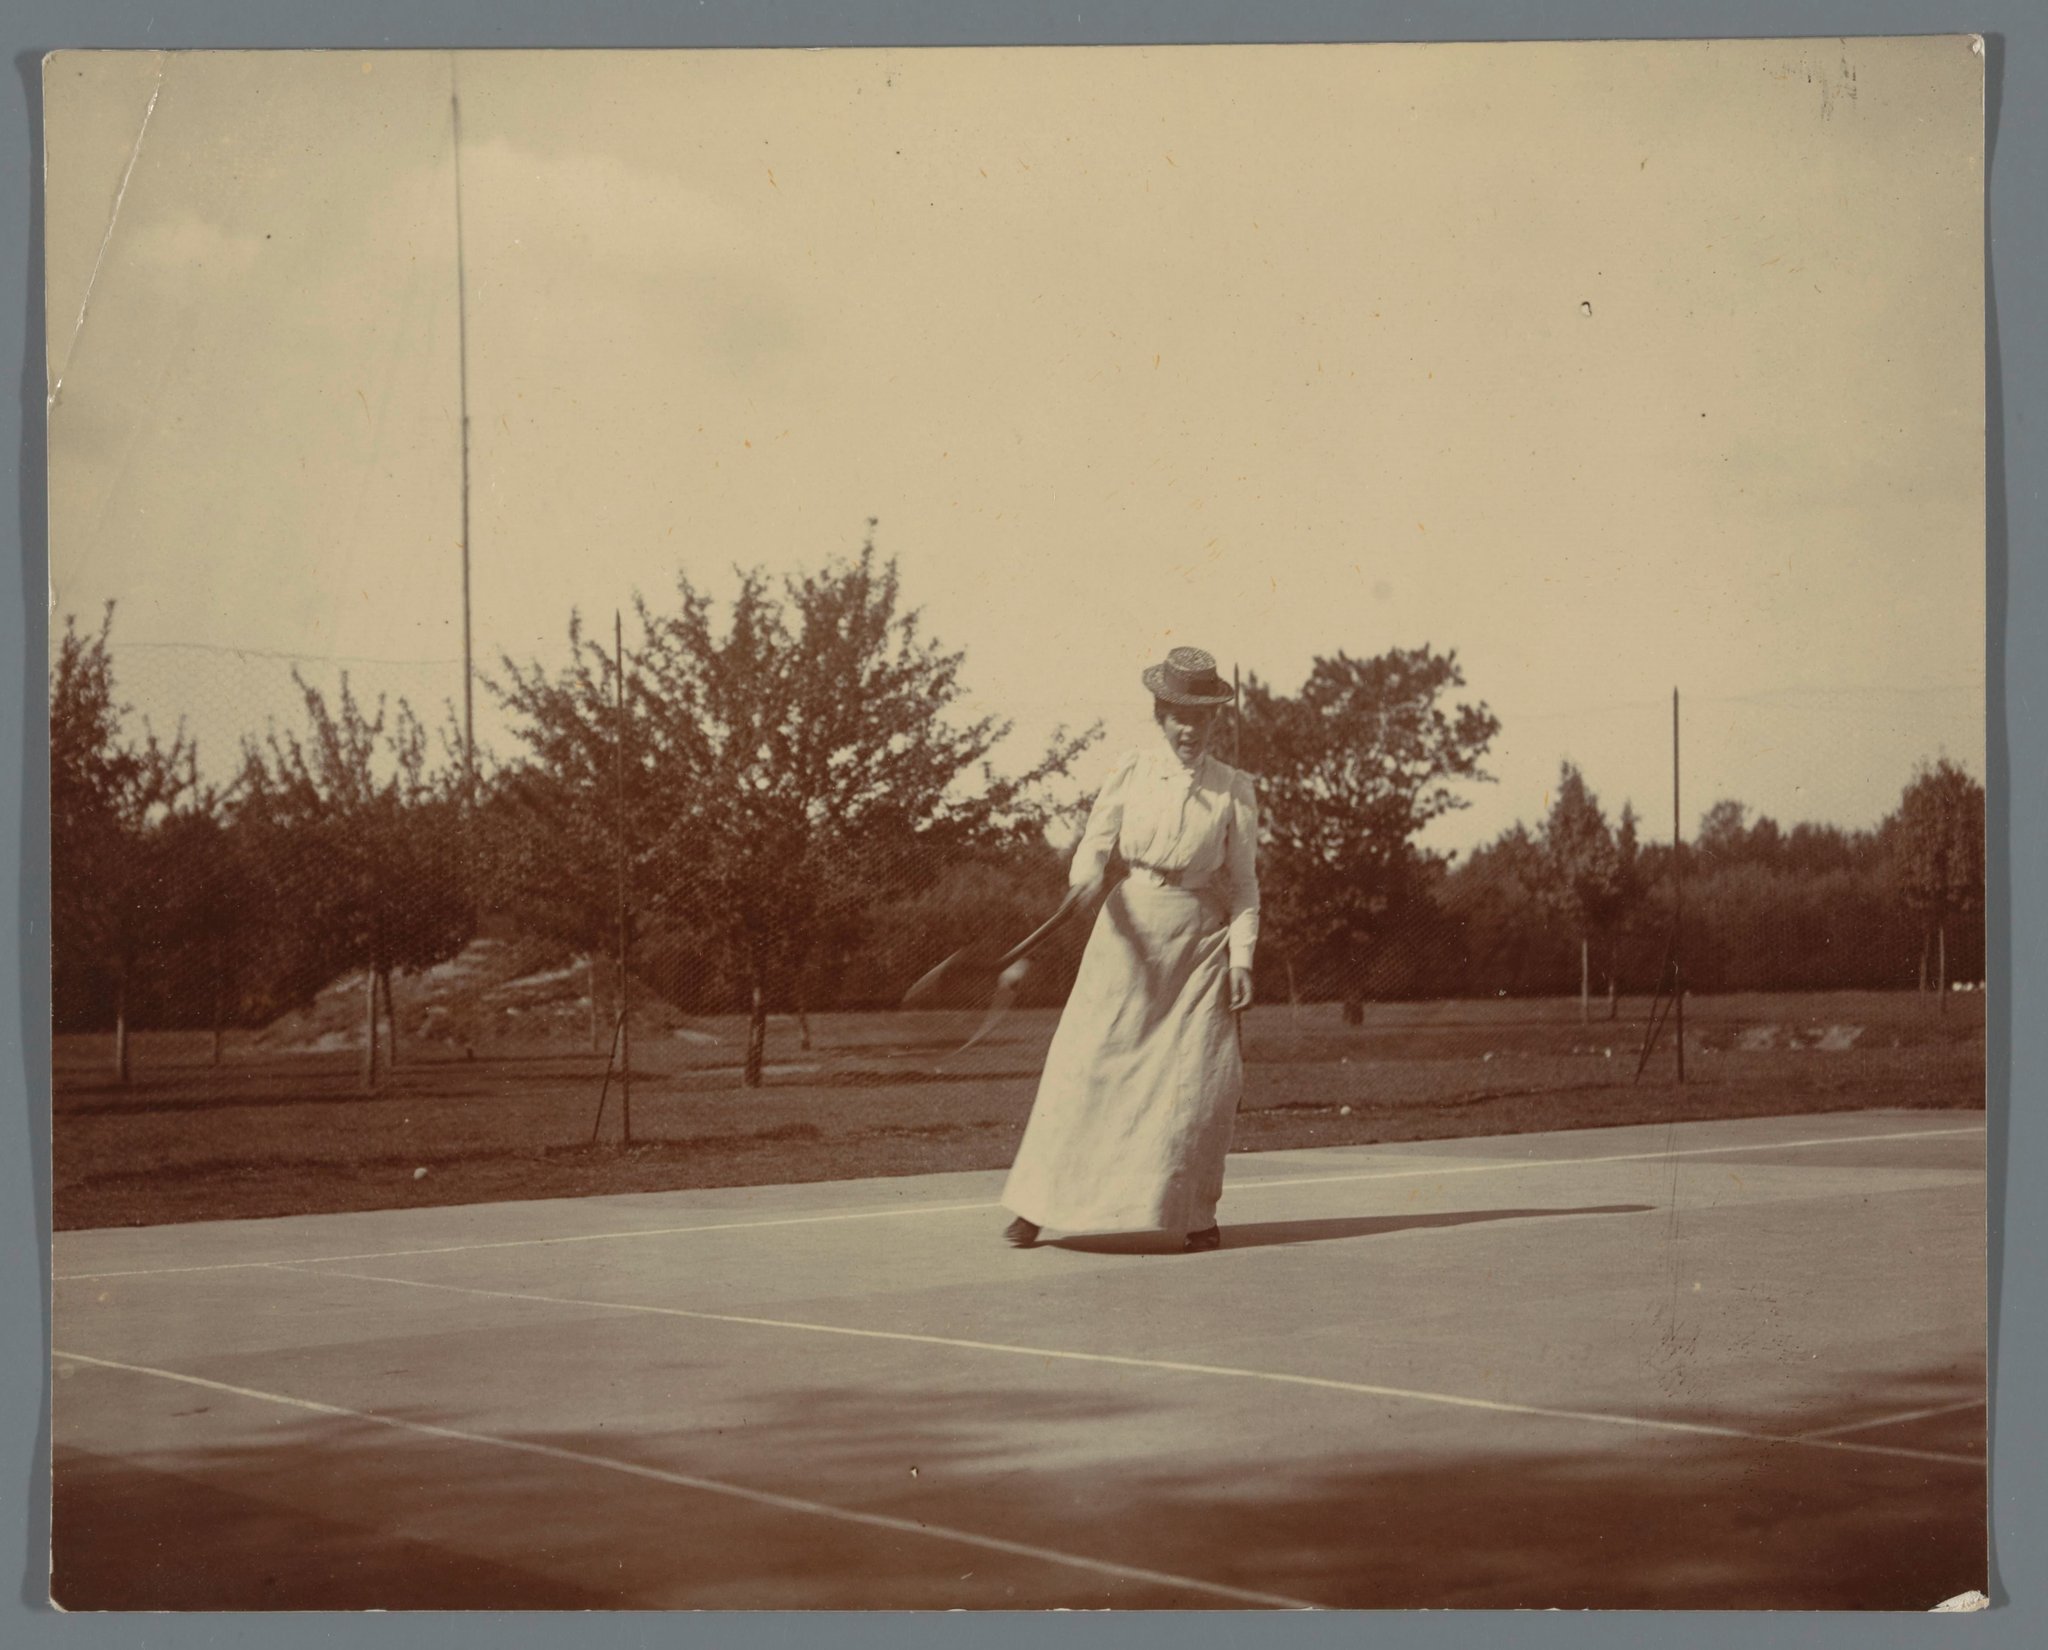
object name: photograph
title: Portret van Cornelia Hendrika Jonker op de tennisbaan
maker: cornelia hendrika jonker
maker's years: 1874-1924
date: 1880-1940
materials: photographic support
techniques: collodion silver print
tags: cornelia hendrika jonker, tennis, lawn-tennis, historical persons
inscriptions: annotation: ‘tante Cor’